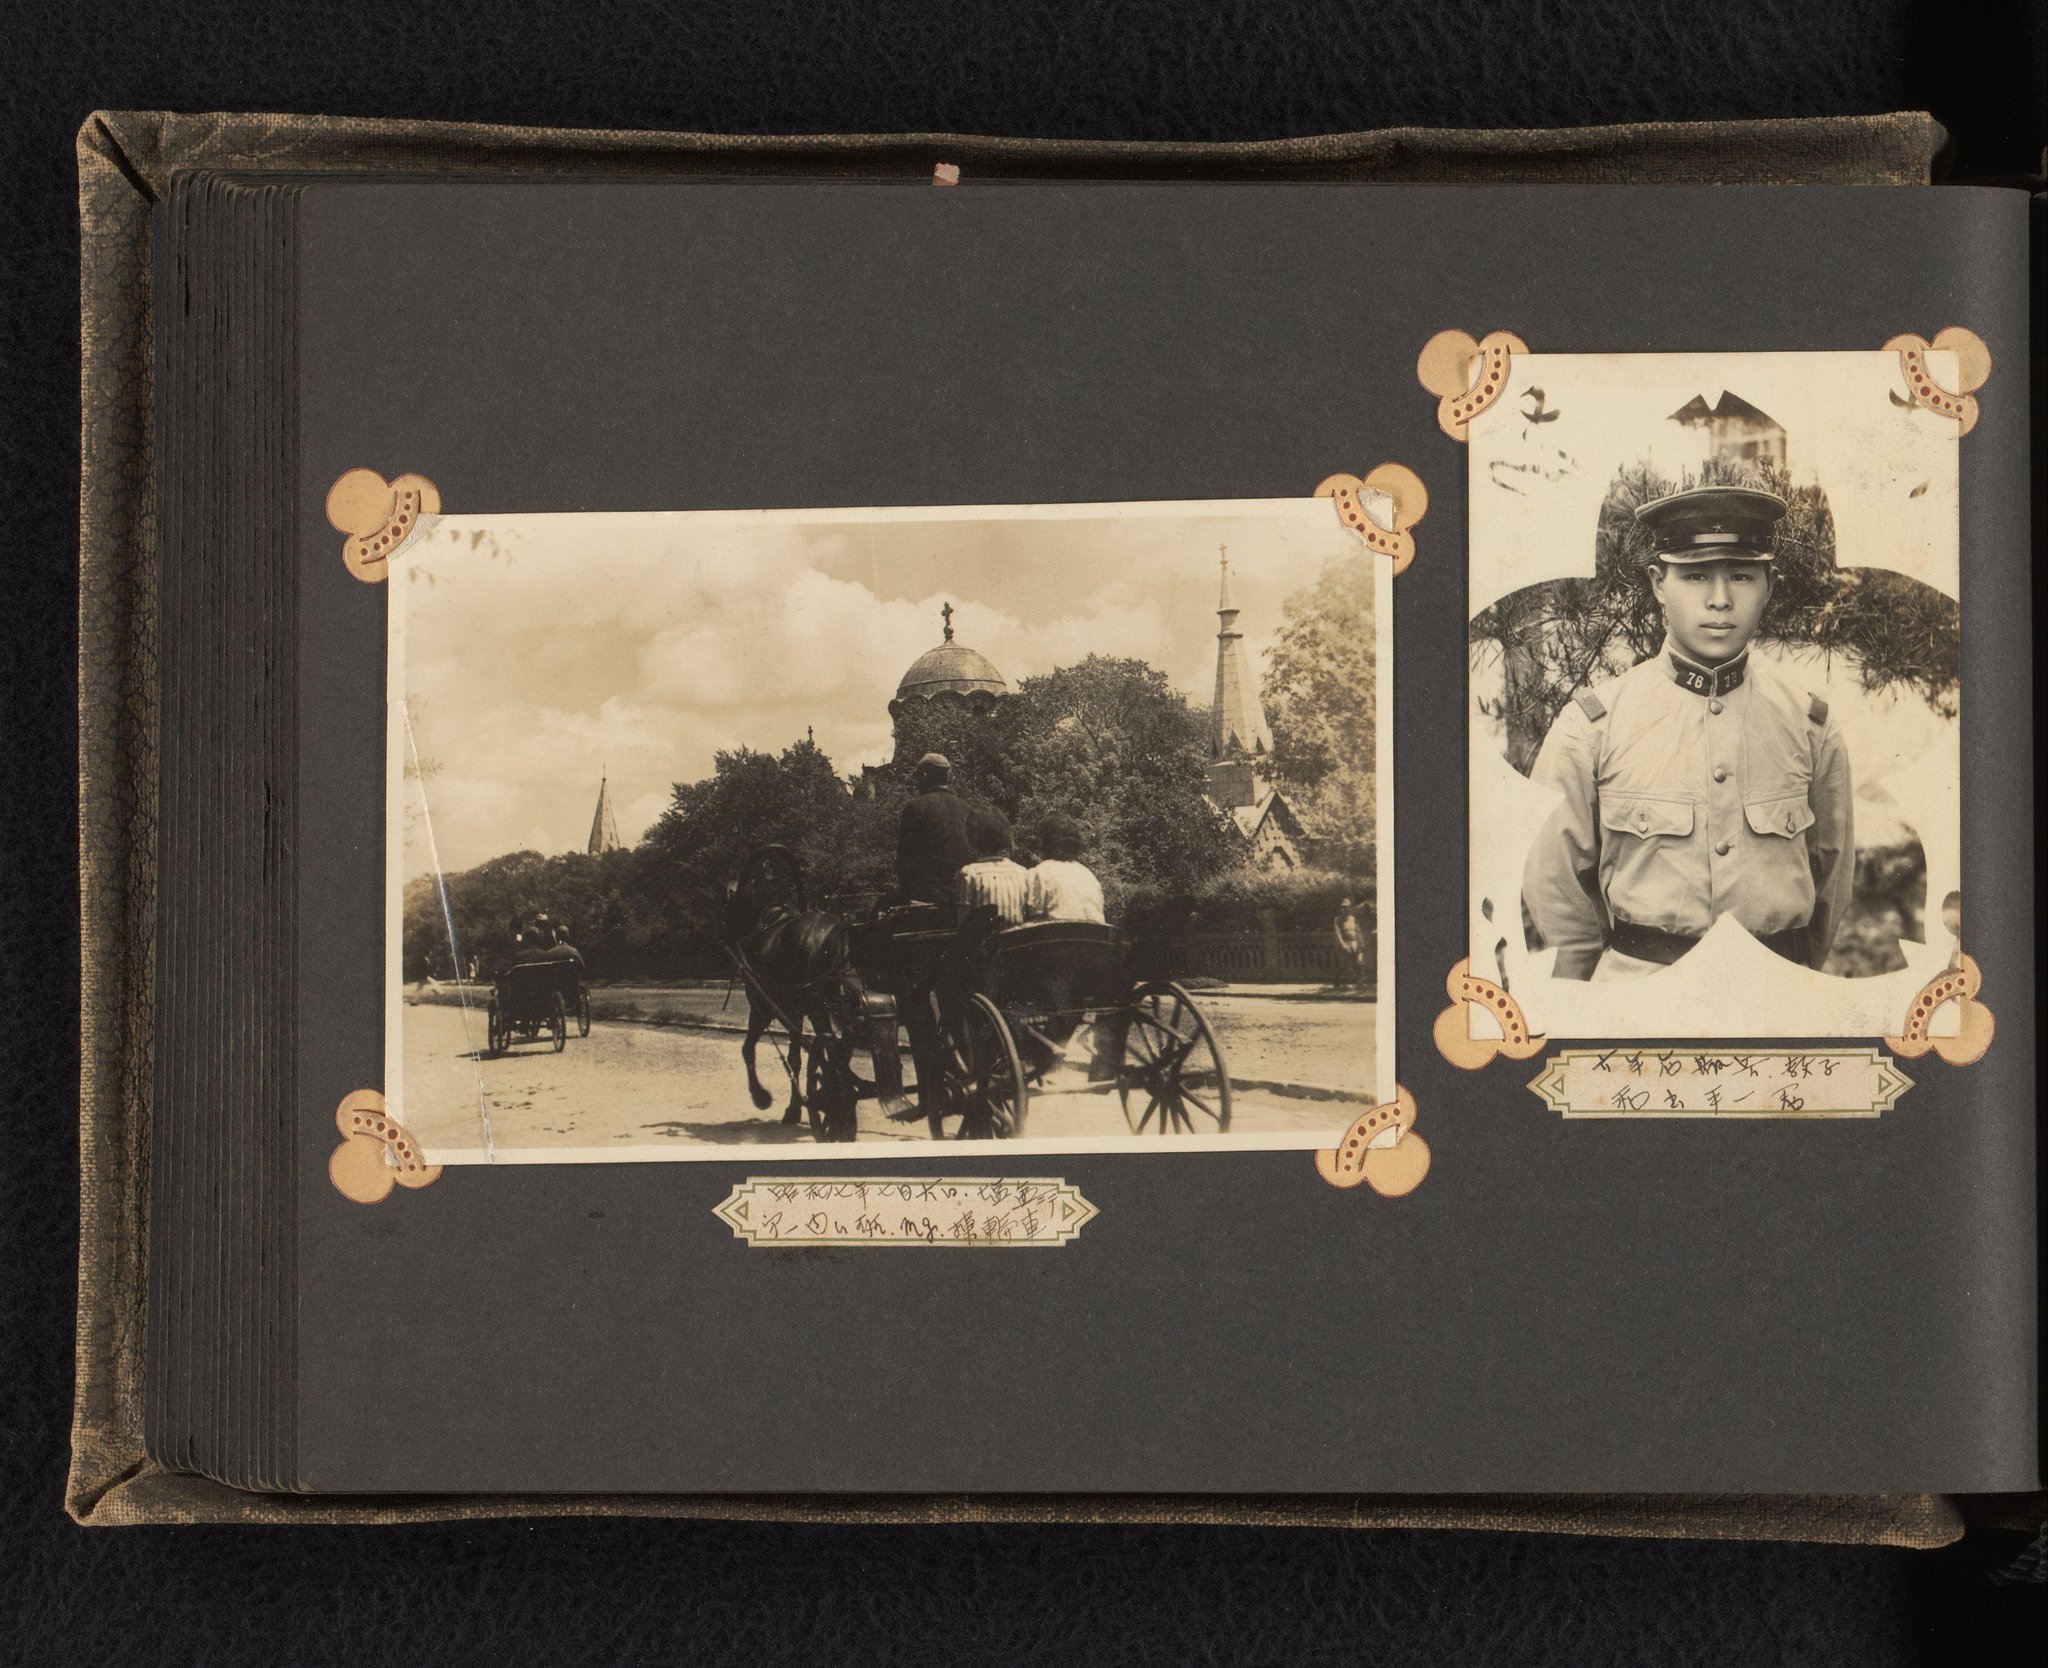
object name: photograph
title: Twee paardenkoetsen op een weg, en een portret van een onbekende Japanse soldaat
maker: Anonymous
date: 1930-1940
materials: paper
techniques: gelatin silver print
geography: korea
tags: four-wheeled, animal-drawn vehicle, e.g.: cab, carriage, coach, anonymous historical person portrayed, the soldier; the soldier's life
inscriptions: inscription: ‘[...]’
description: Deze foto's zijn onderdeel van een album.